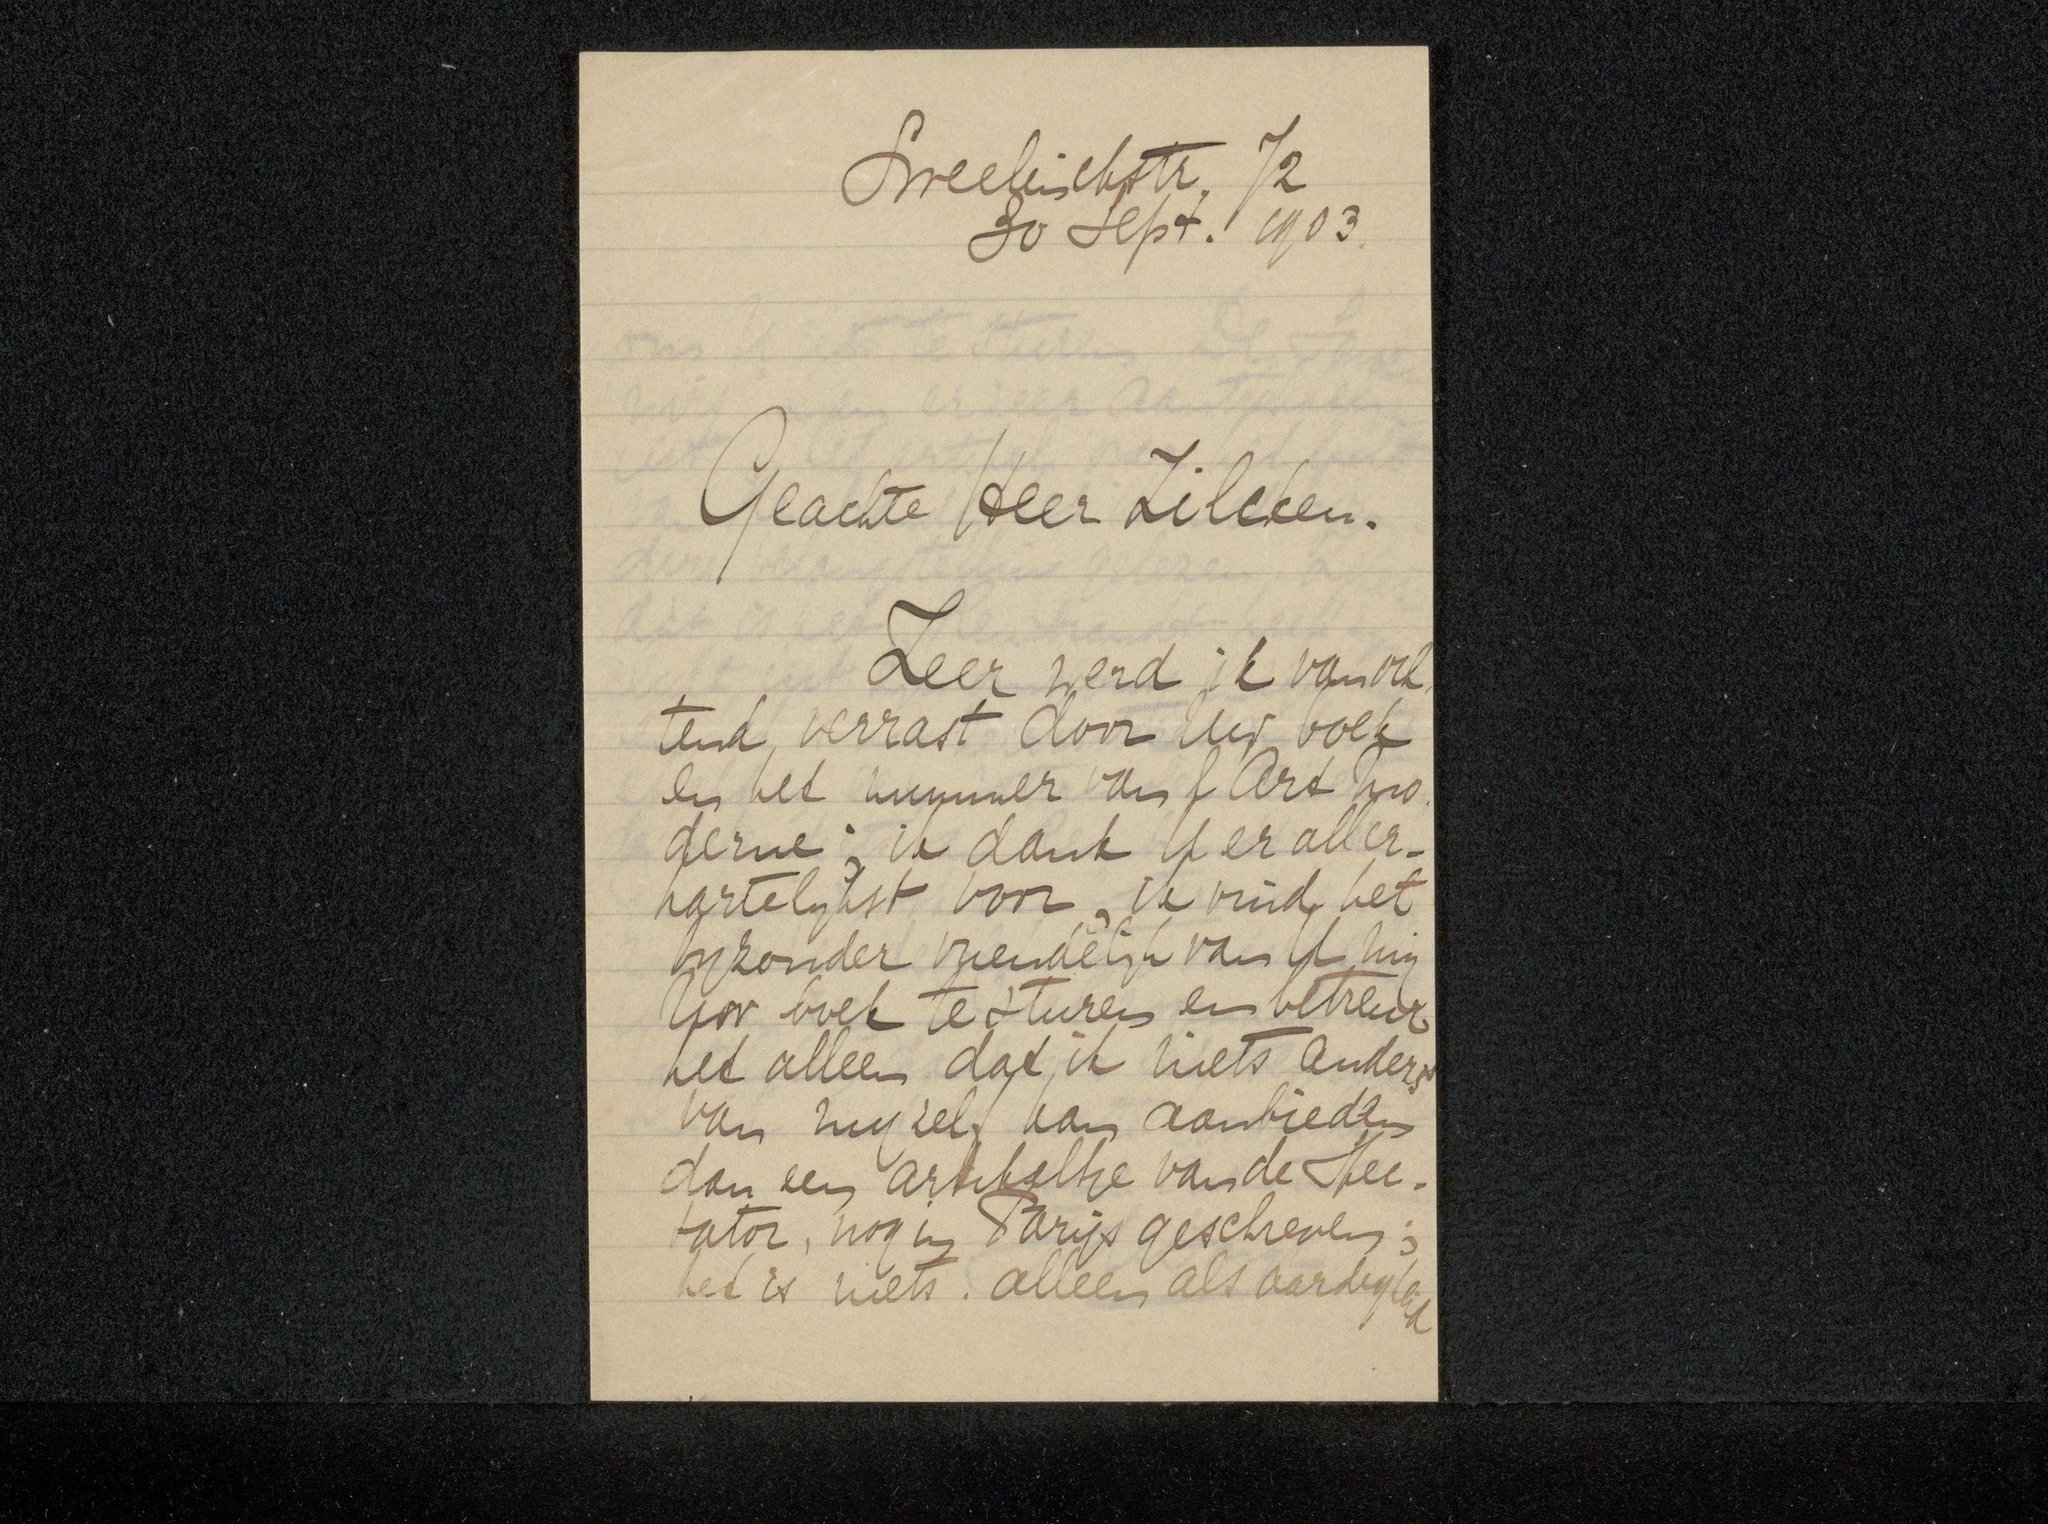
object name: letter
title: Brief aan Philip Zilcken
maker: johanna suzanne goekoop-de jongh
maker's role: kunsthistoricus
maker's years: 1877-1946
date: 1903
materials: ink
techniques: pen, writing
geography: the hague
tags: print maker, rembrandt van rijn, painter, draughtsman, philip zilcken, literature ~ arts, printed matter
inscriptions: collector's mark: ‘RPK’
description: Met deze brief samen is artikel RP-D-1982-43-GOEKOOP-DEJONGH(J.)-DOC.1 verstuurd.